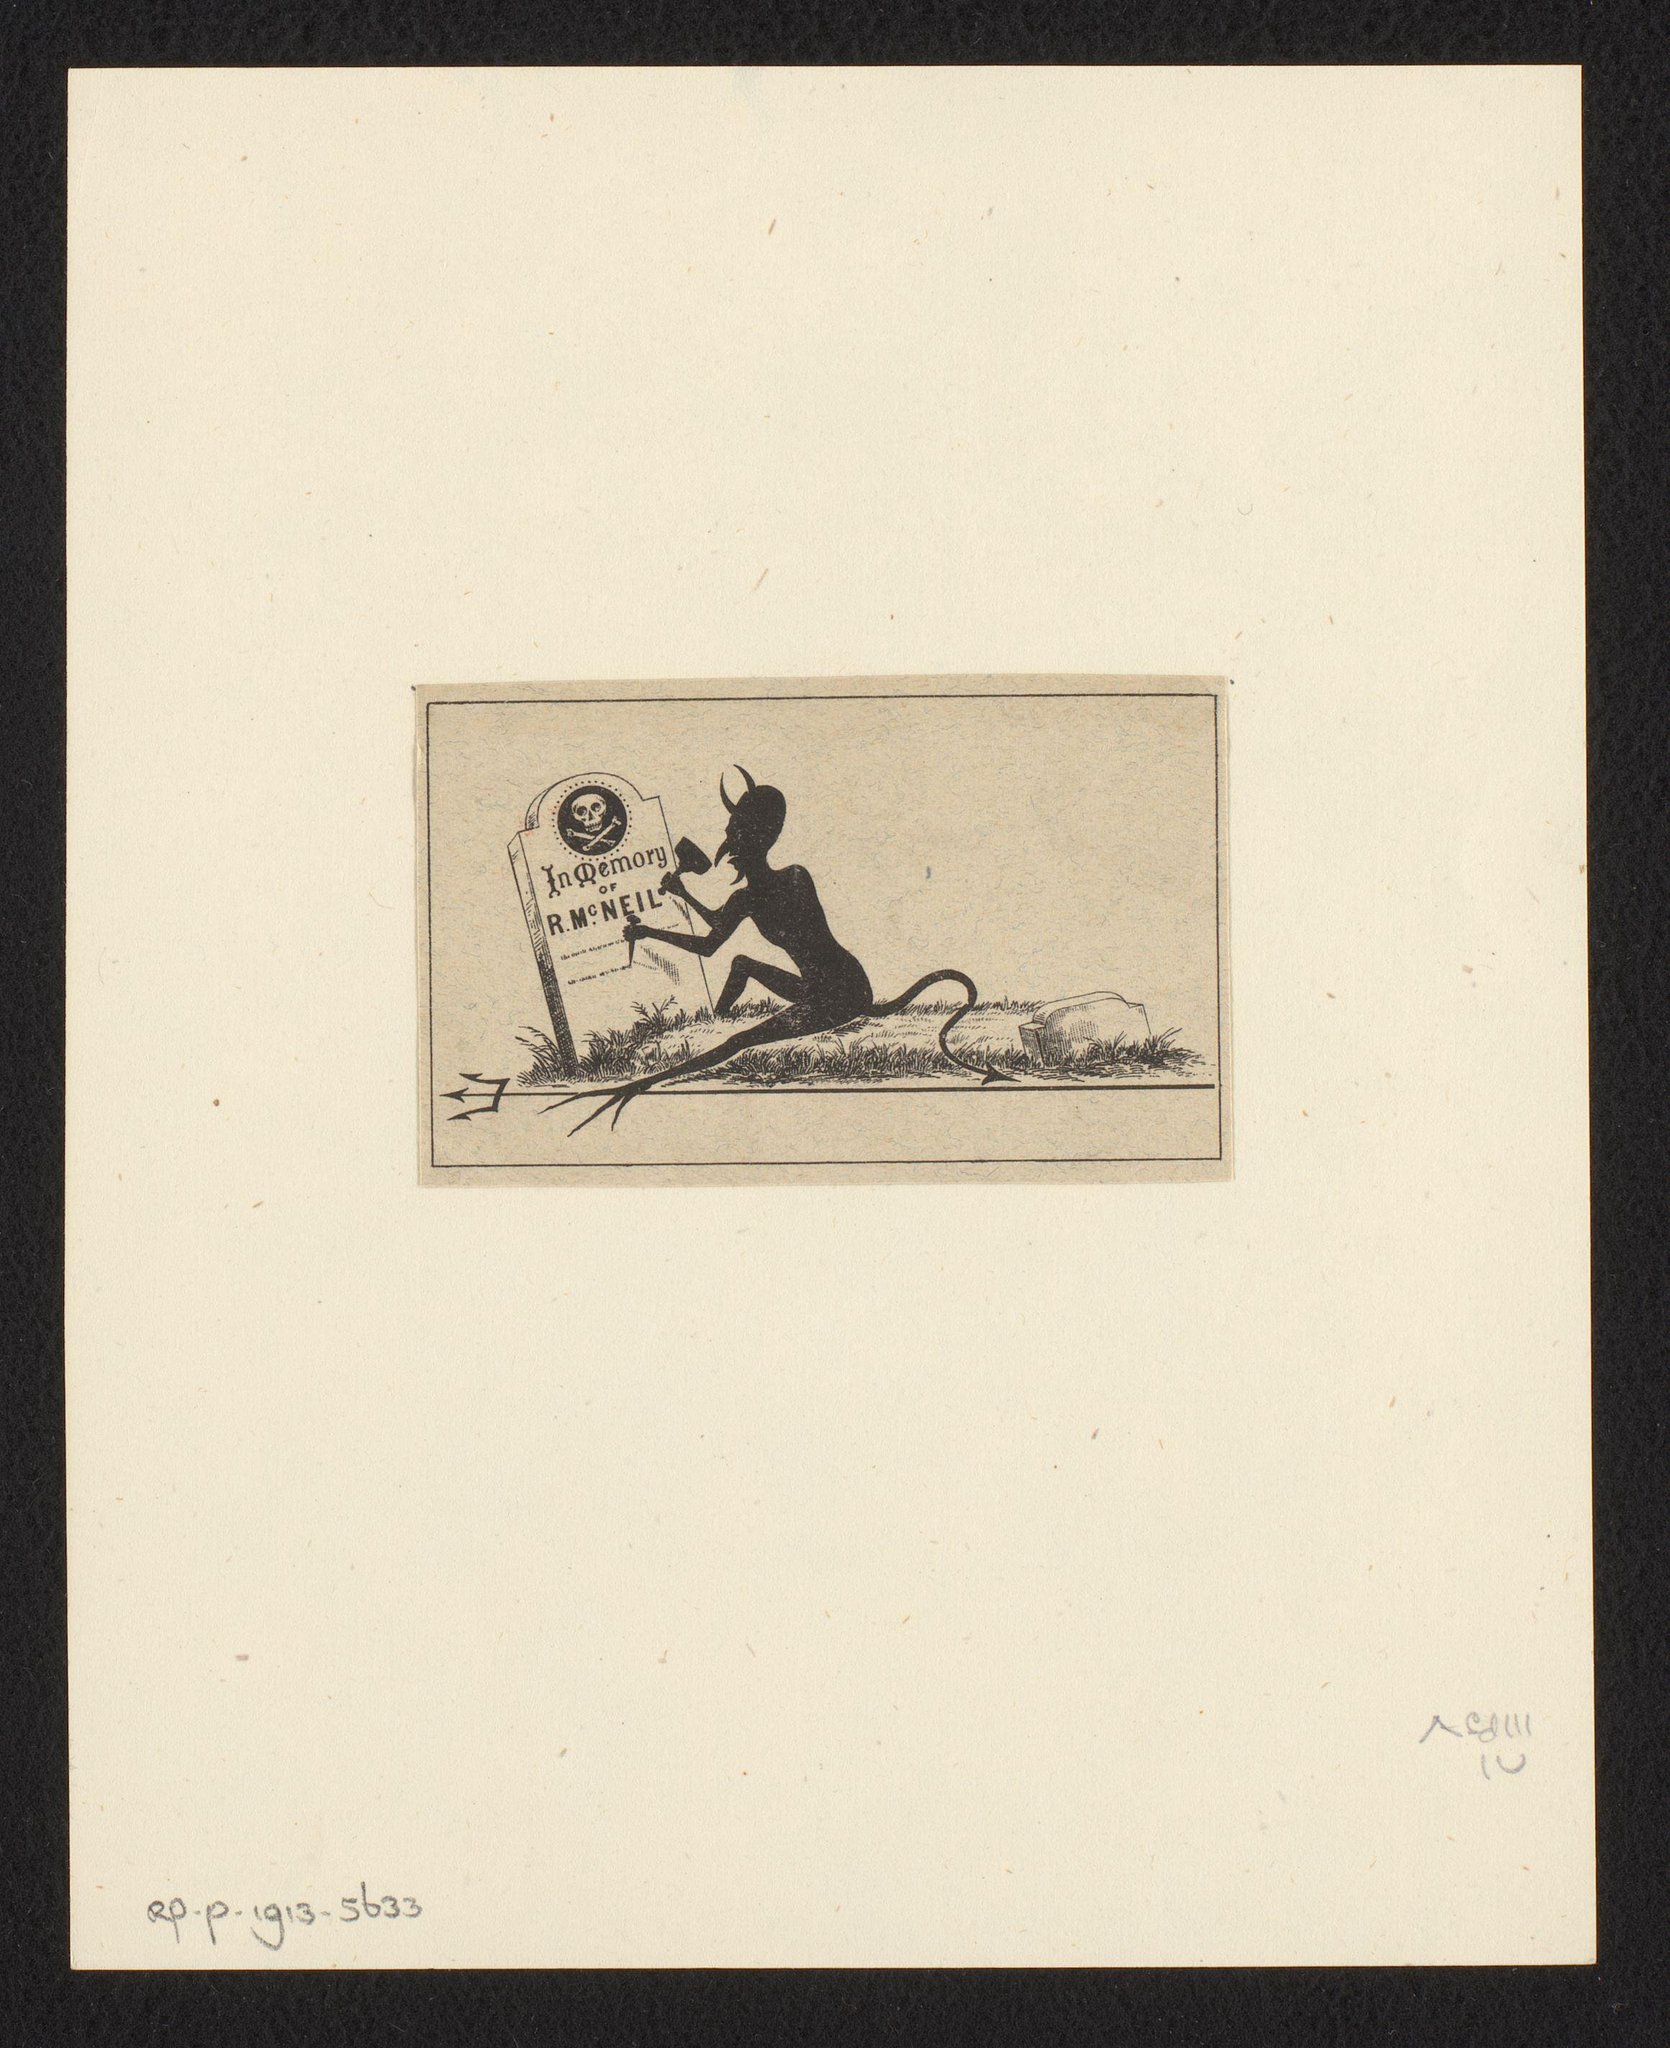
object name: photomechanical print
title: Herdenkingskaart voor R. McNeil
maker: Anonymous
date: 1825-1875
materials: paper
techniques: printing block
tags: upright gravestone, devil(s) and demons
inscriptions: collector's mark: Lugt 2233, collector's mark: Lugt 2760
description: Een duivel beitelt de tekst 'In memory of R. Mc.Neil' in een grafsteen met een schedel en gekruiste botten bovenin.